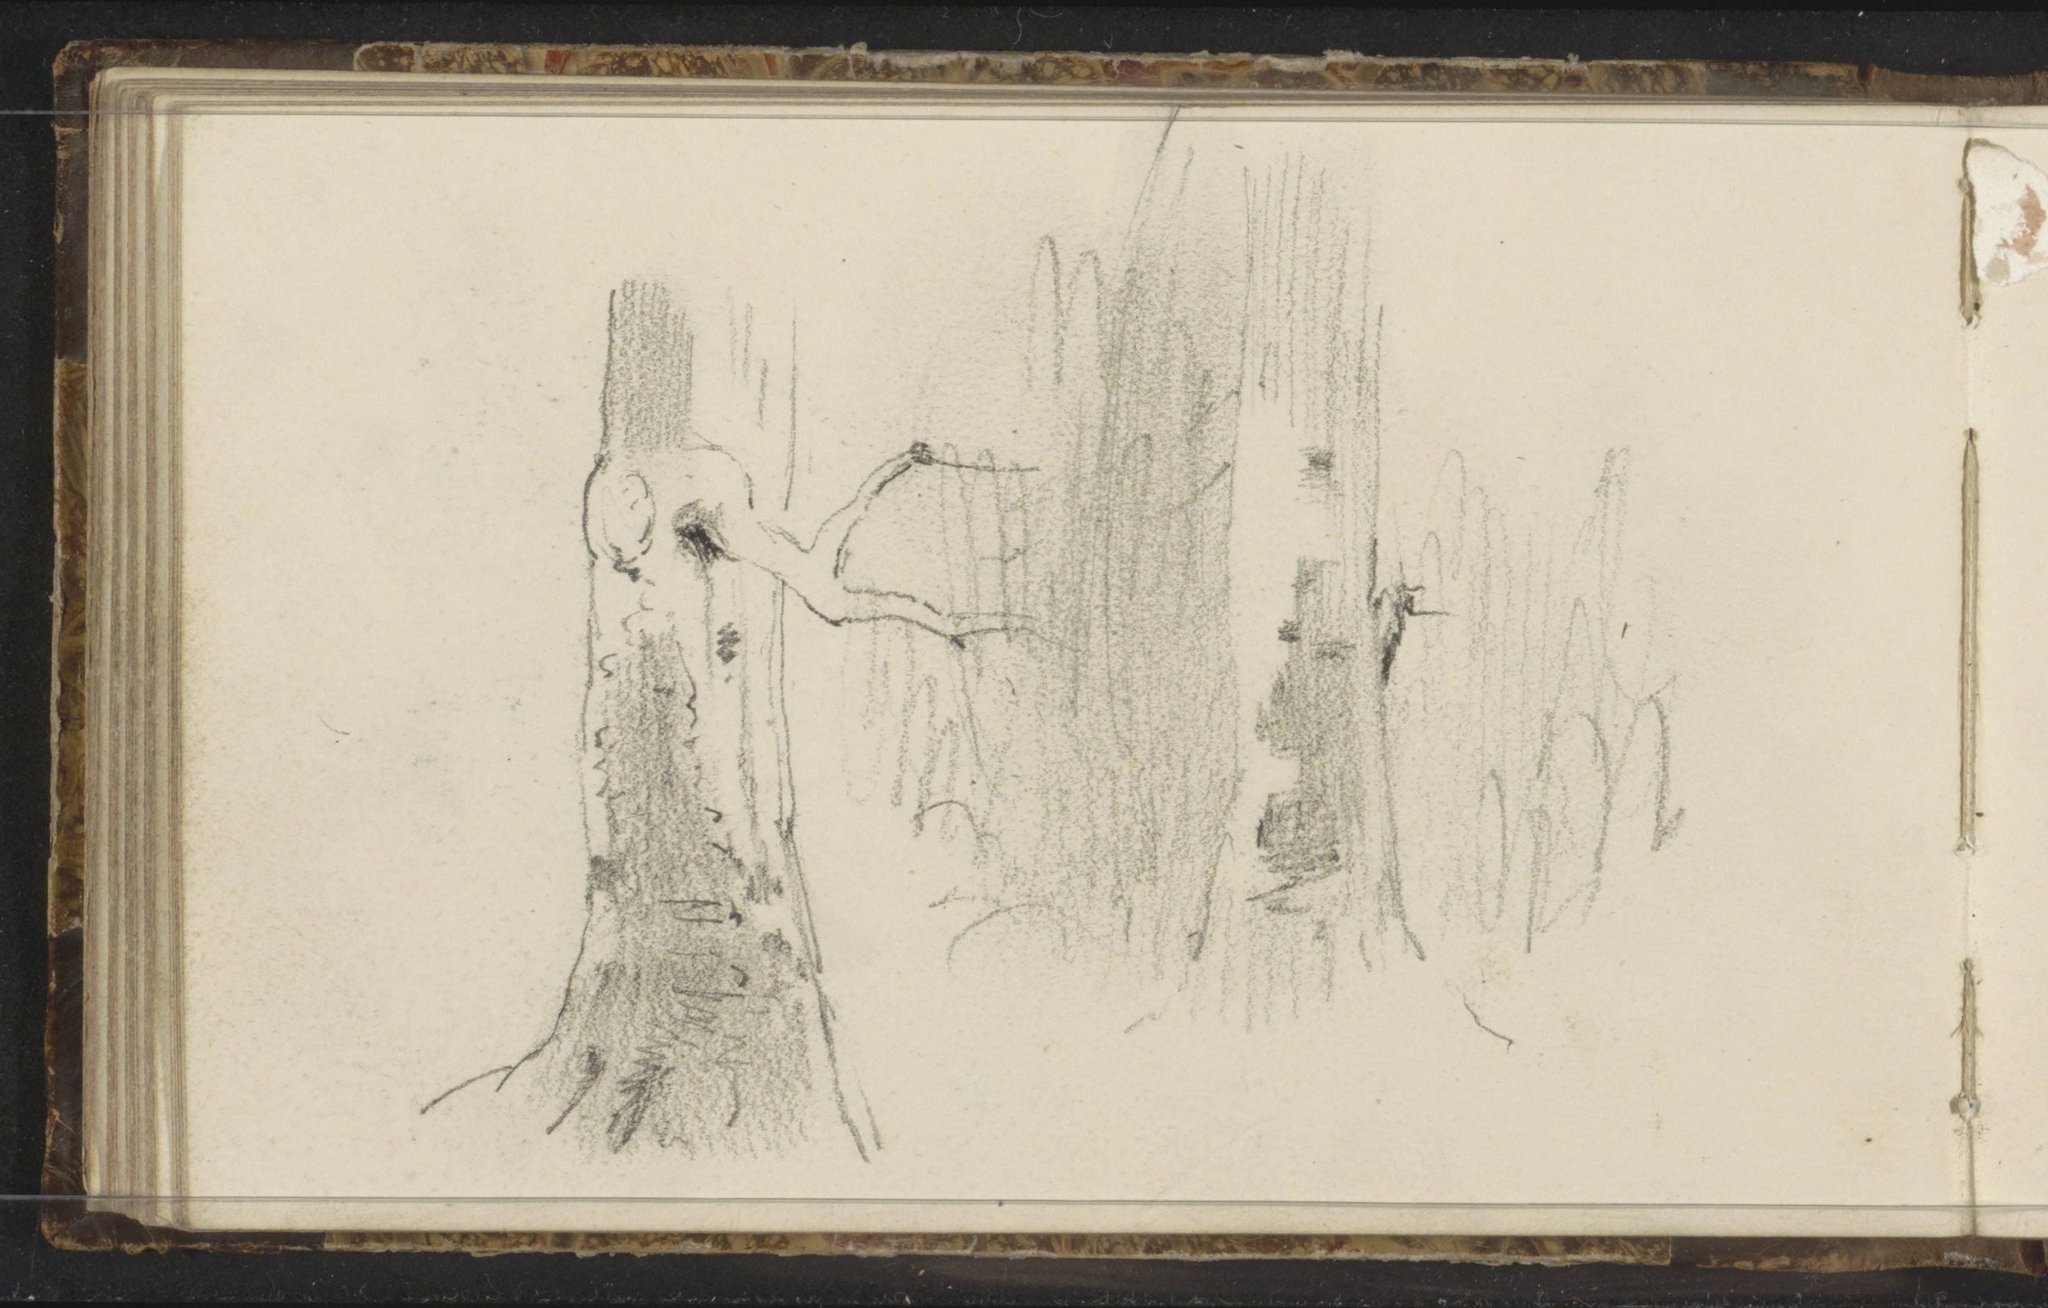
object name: sketchbook leaf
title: Boomstammen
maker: willem hendrik schmidt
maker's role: draughtsman, painter, print maker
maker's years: 1809-1849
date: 1819-1849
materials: paper, pencil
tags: trees (+ stem, trunk)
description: Blad 35 verso uit een schetsboek met 60 bladen.